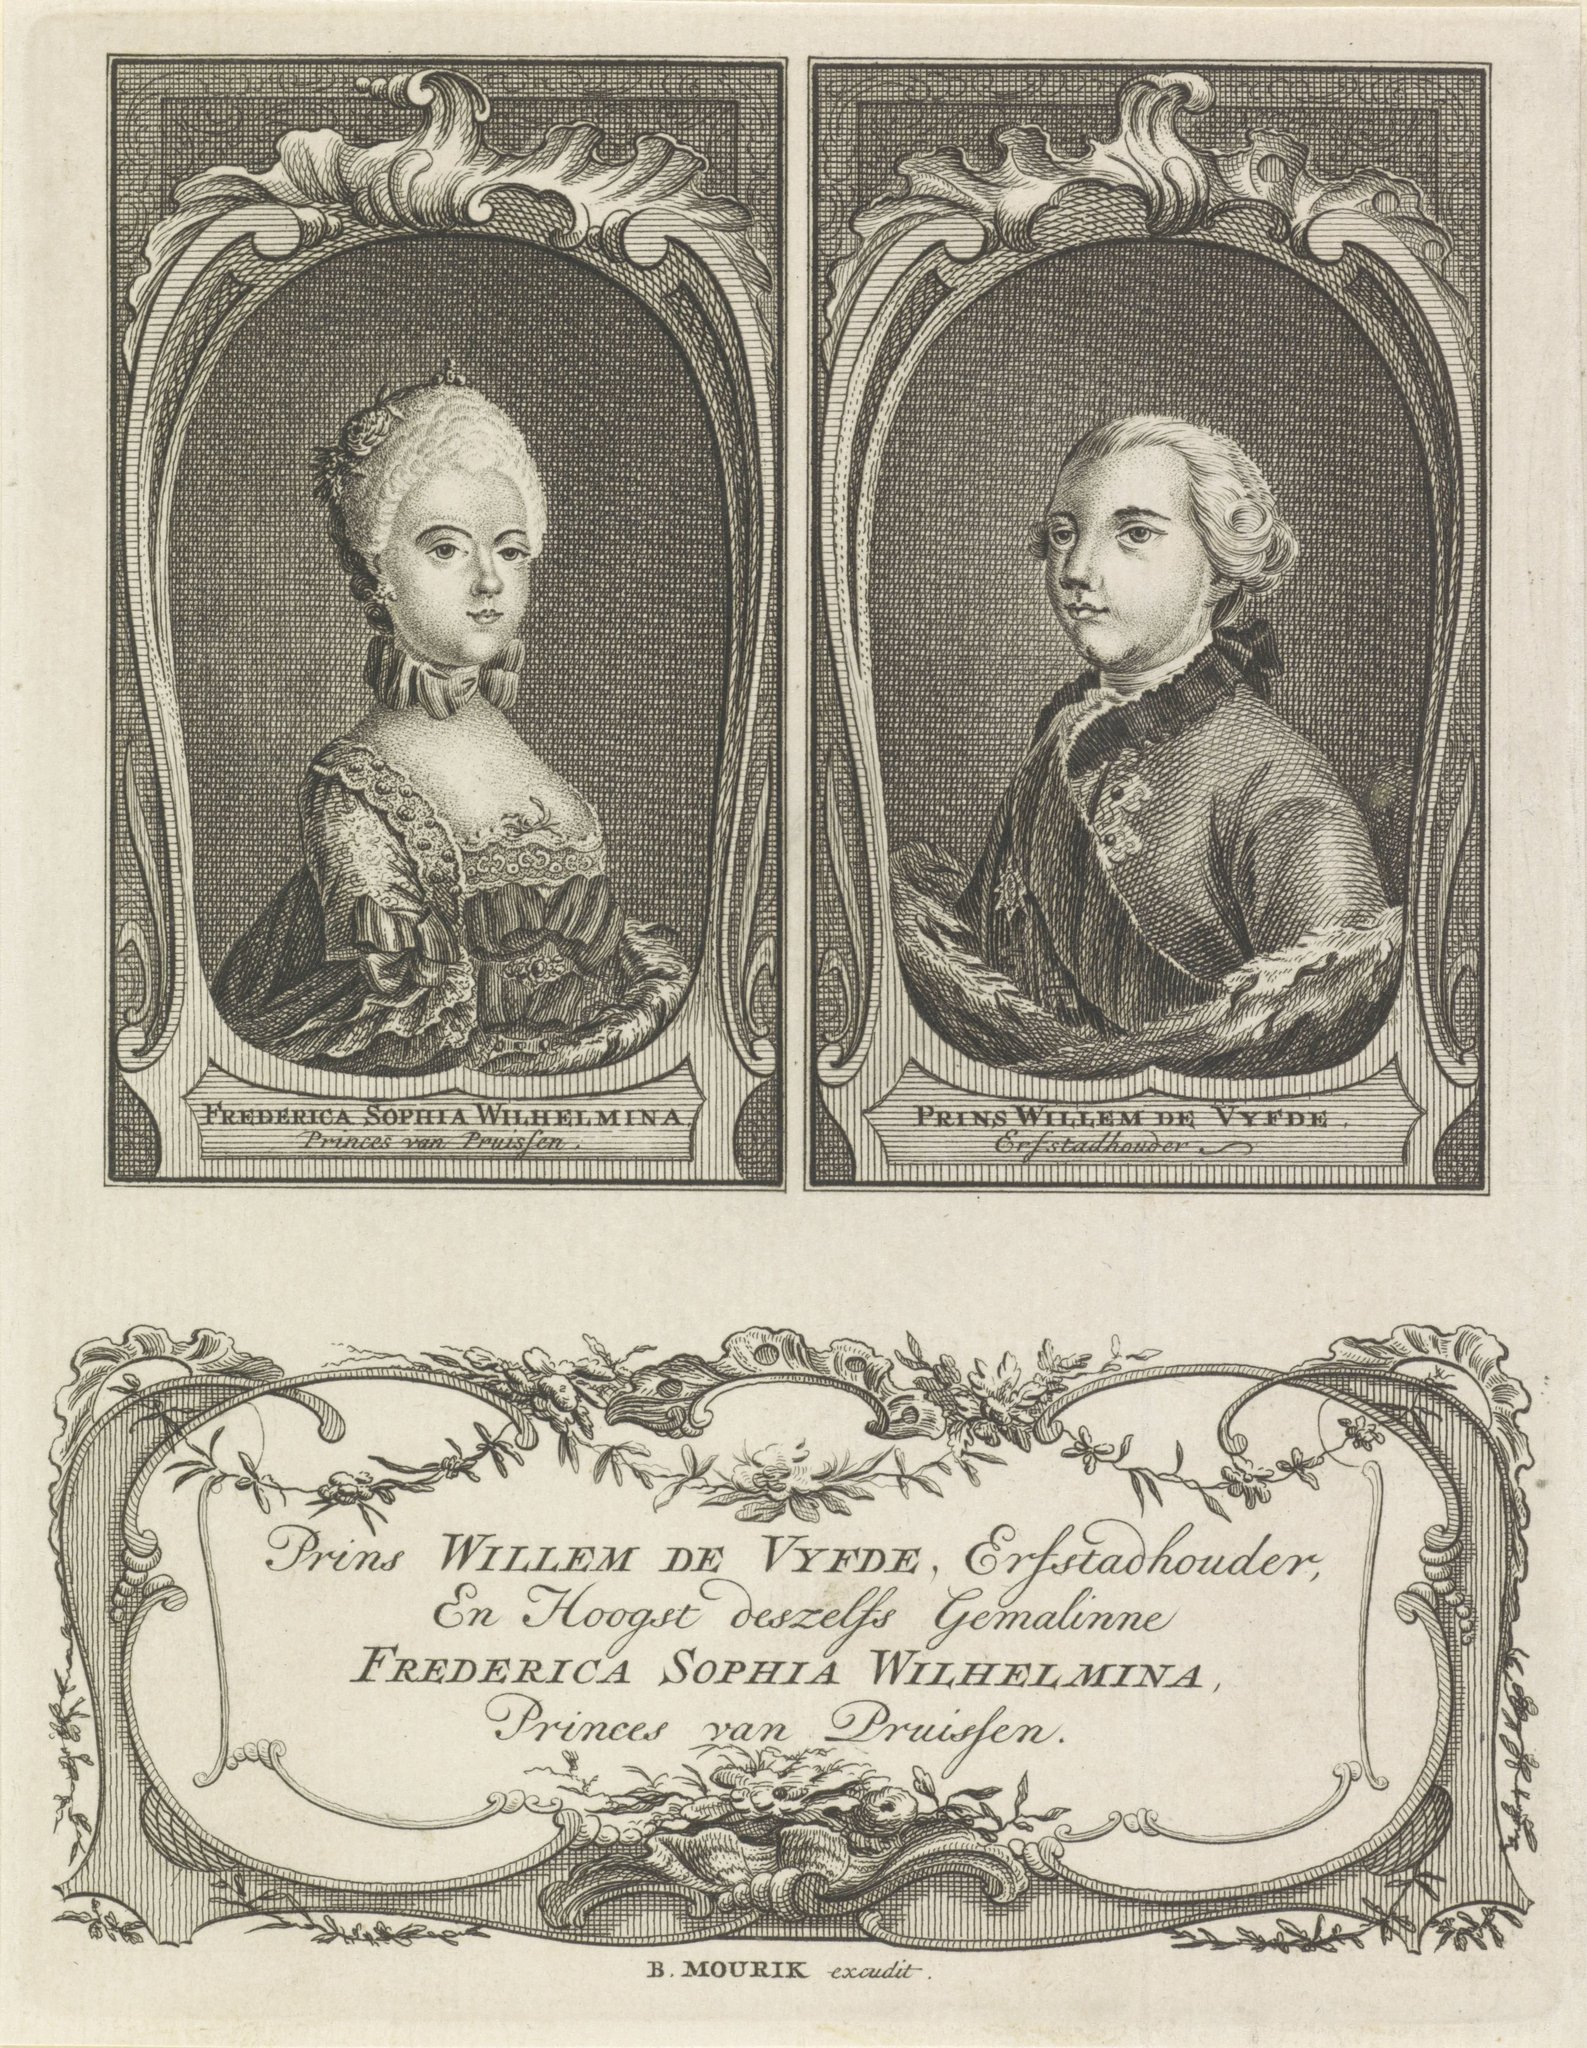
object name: print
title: Portretten van Wilhelmina van Pruisen en Willem V, prins van Oranje-Nassau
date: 1767-1791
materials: paper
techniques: engraving, etching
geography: low countries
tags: the hague, william v (prince of orange), wilhelmina of prussia (princess of orange)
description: De hier vermelde titel verwijst naar de hoogst verkregen titel van de geportretteerde, niet per se naar de titel die de geportretteerde op deze voorstelling draagt.